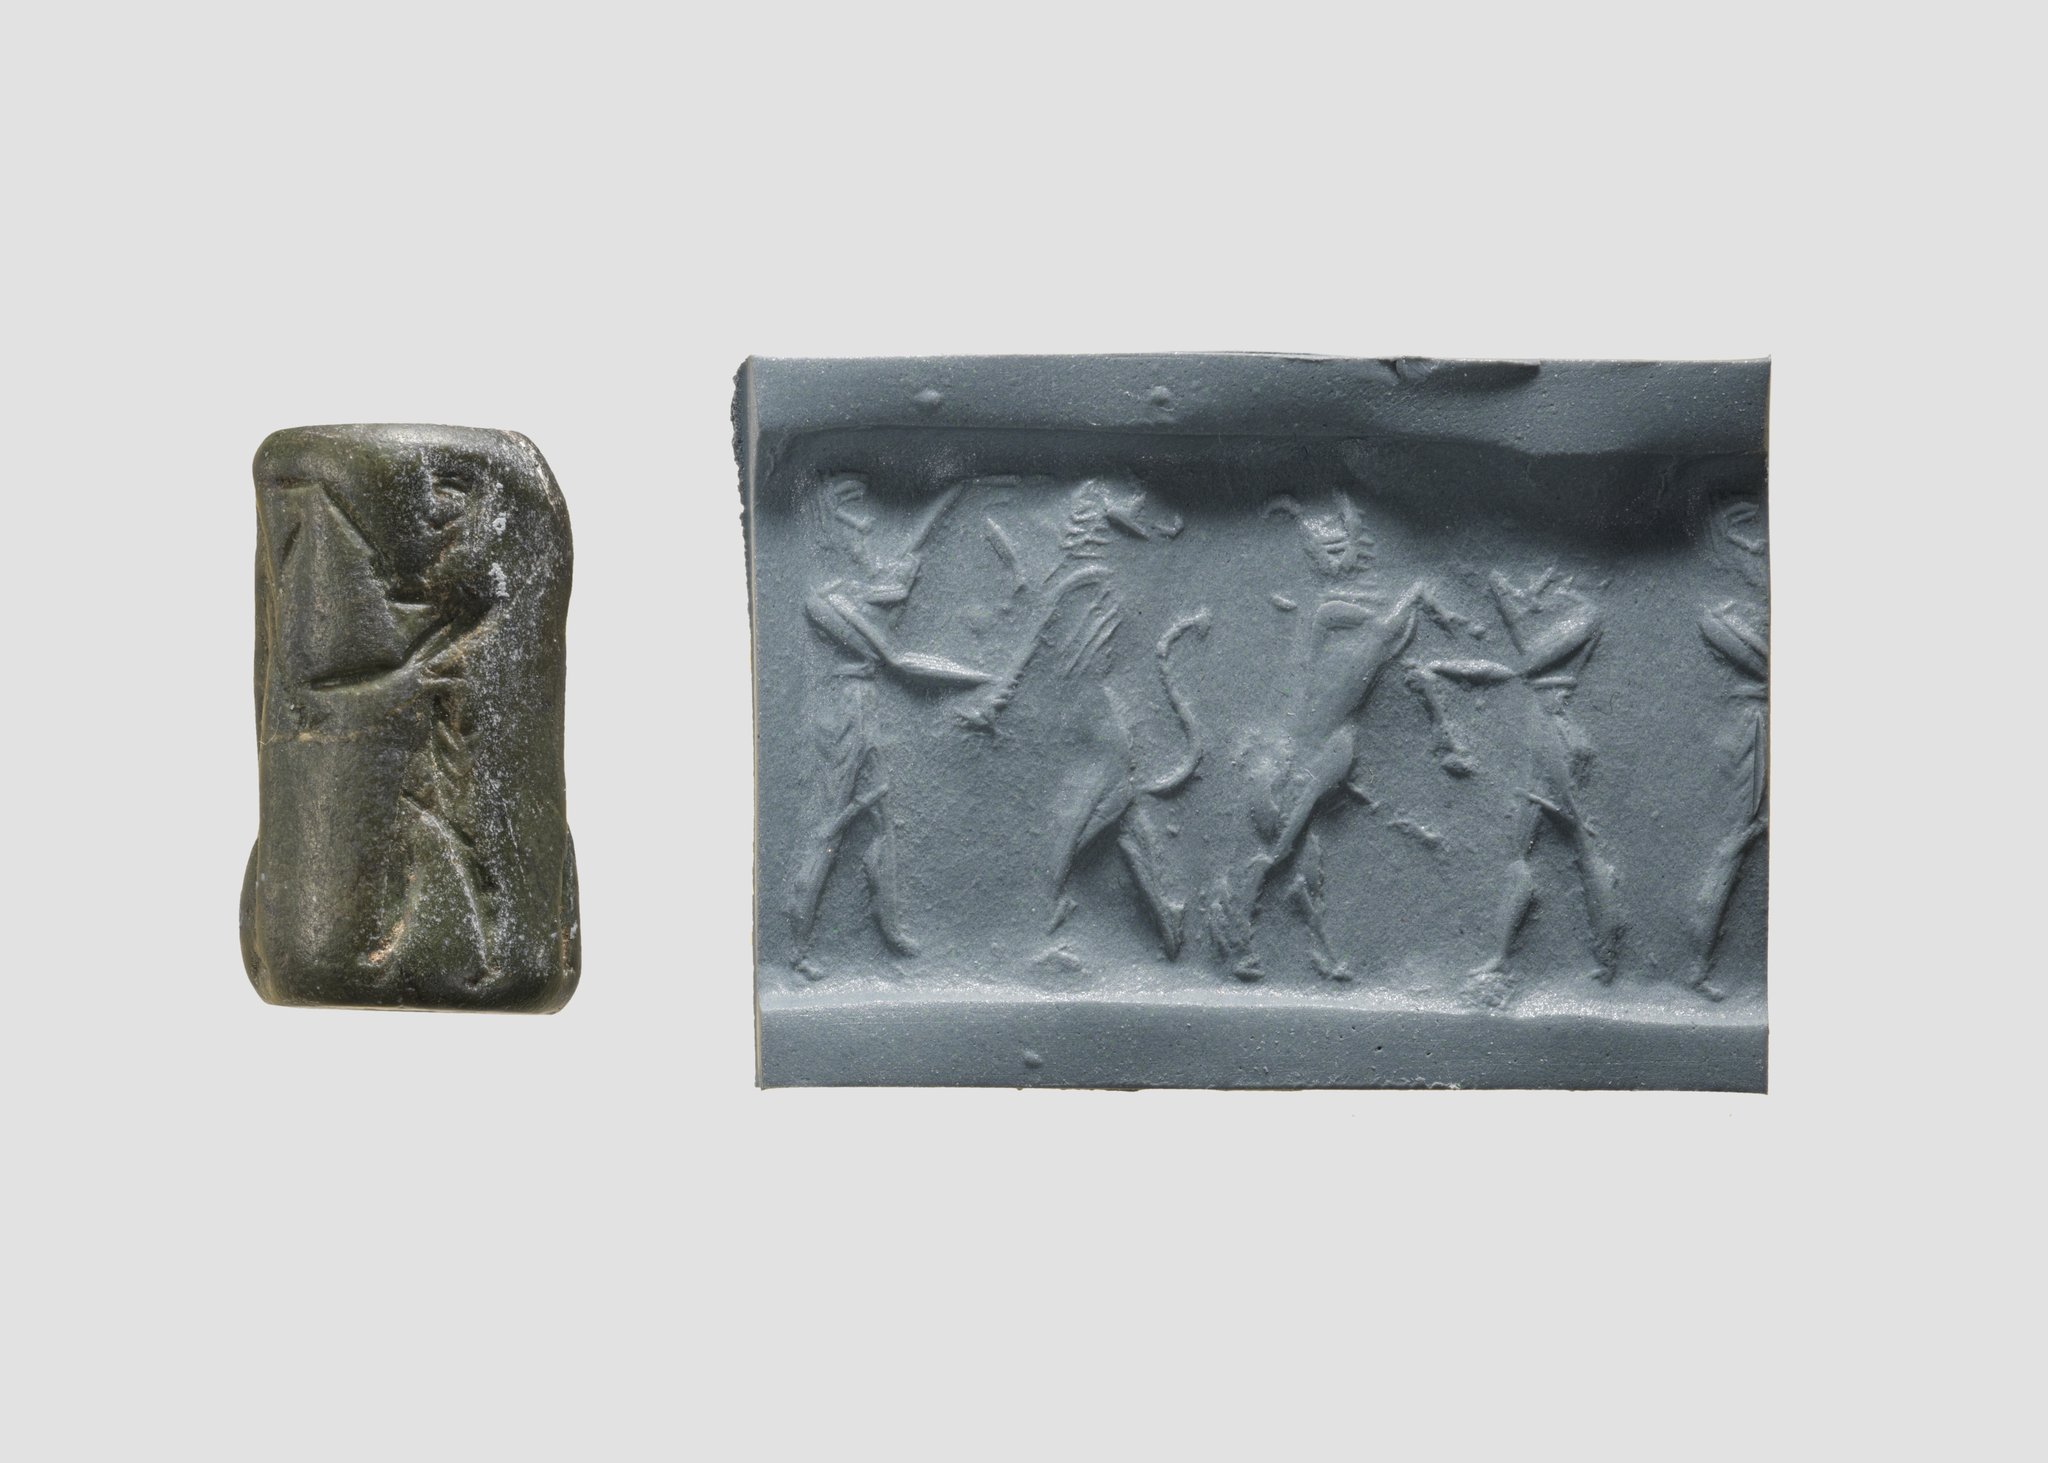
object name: cylinder seal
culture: akkadian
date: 2350-2150 BCE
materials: stone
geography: mesopotamia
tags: animals